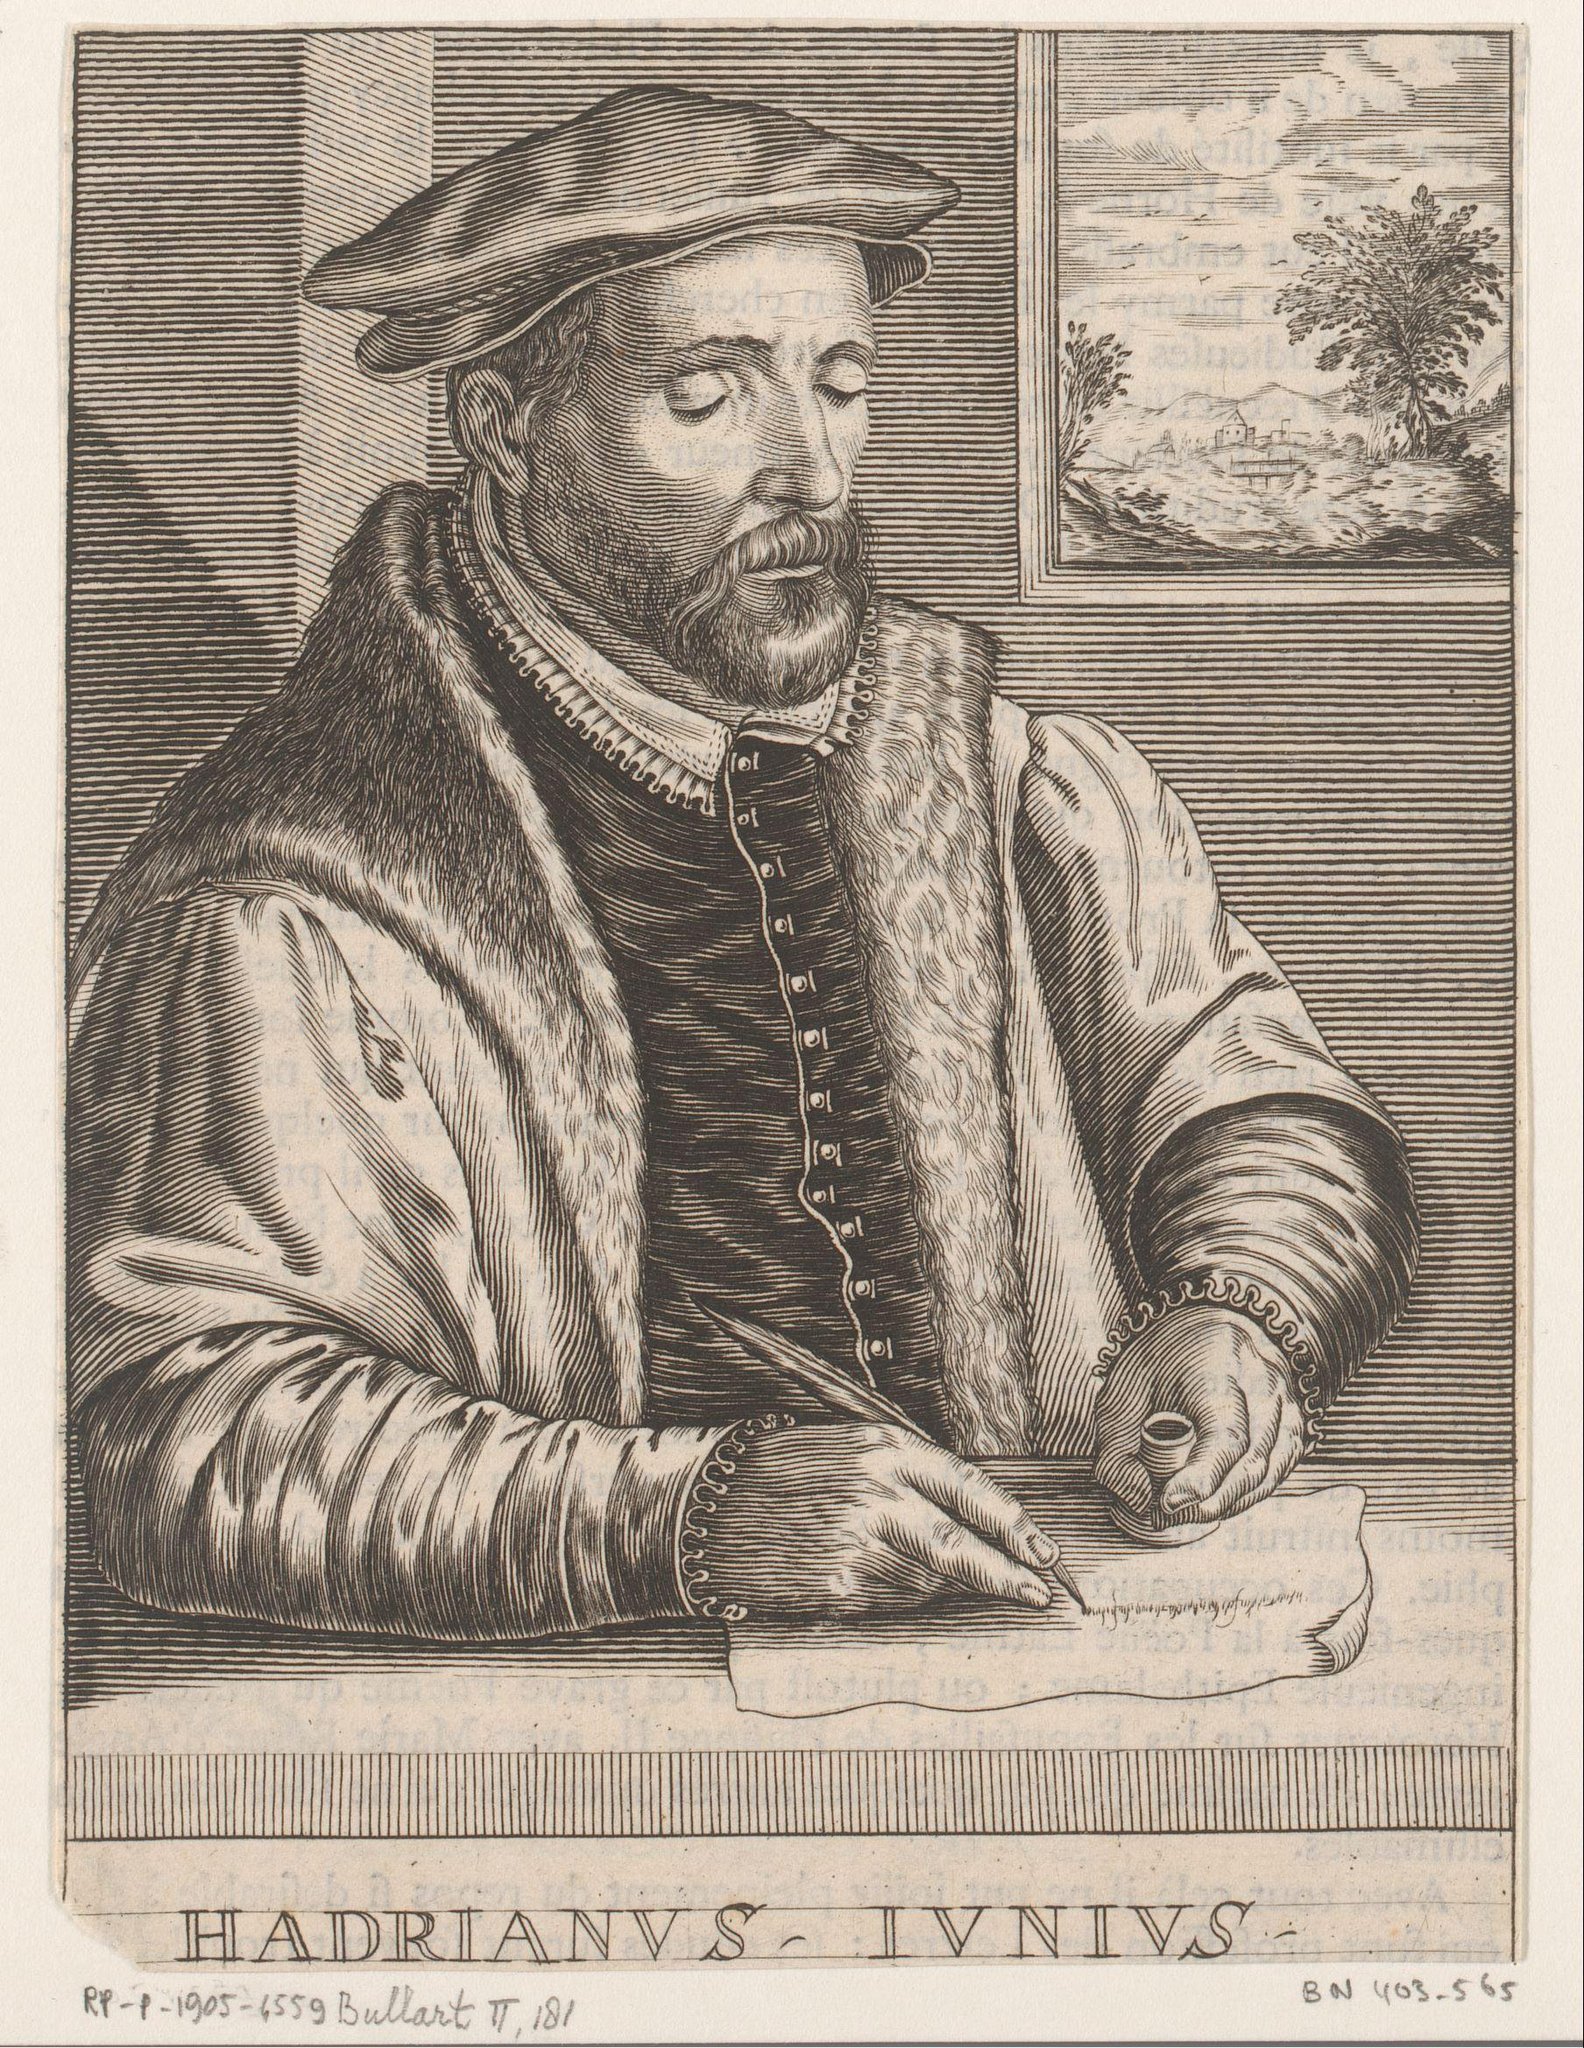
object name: print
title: Portret van Hadrianus Junius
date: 1682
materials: paper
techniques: engraving, letterpress printing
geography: brussels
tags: hoorn (north holland), hadrianus junius, historical persons, physician, doctor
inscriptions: collector's mark: Lugt 2228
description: Prent gebruikt voor: Bullart, Isaac. Académie des Sciences et Arts contenant les vies et éloges his. des hommes illustres qui ont excellé en ces professions depuis environ quatre siècles. Brussel: François Foppens, 1682. Het boek werd in 1682 eveneens in Amsterdam uitgegeven door de erfgenamen van Daniel Elzevier. Ieder portret betreft een illustratie bij de biografie van een kunstenaar of geleerde. De meeste portretten werden door Nicolas de Larmessin vervaardigd (162), 93 door De Boulonois en een derde door ongeïdentificeerde prentmakers. Dit betreft een illustratie op p. 181, deel II.